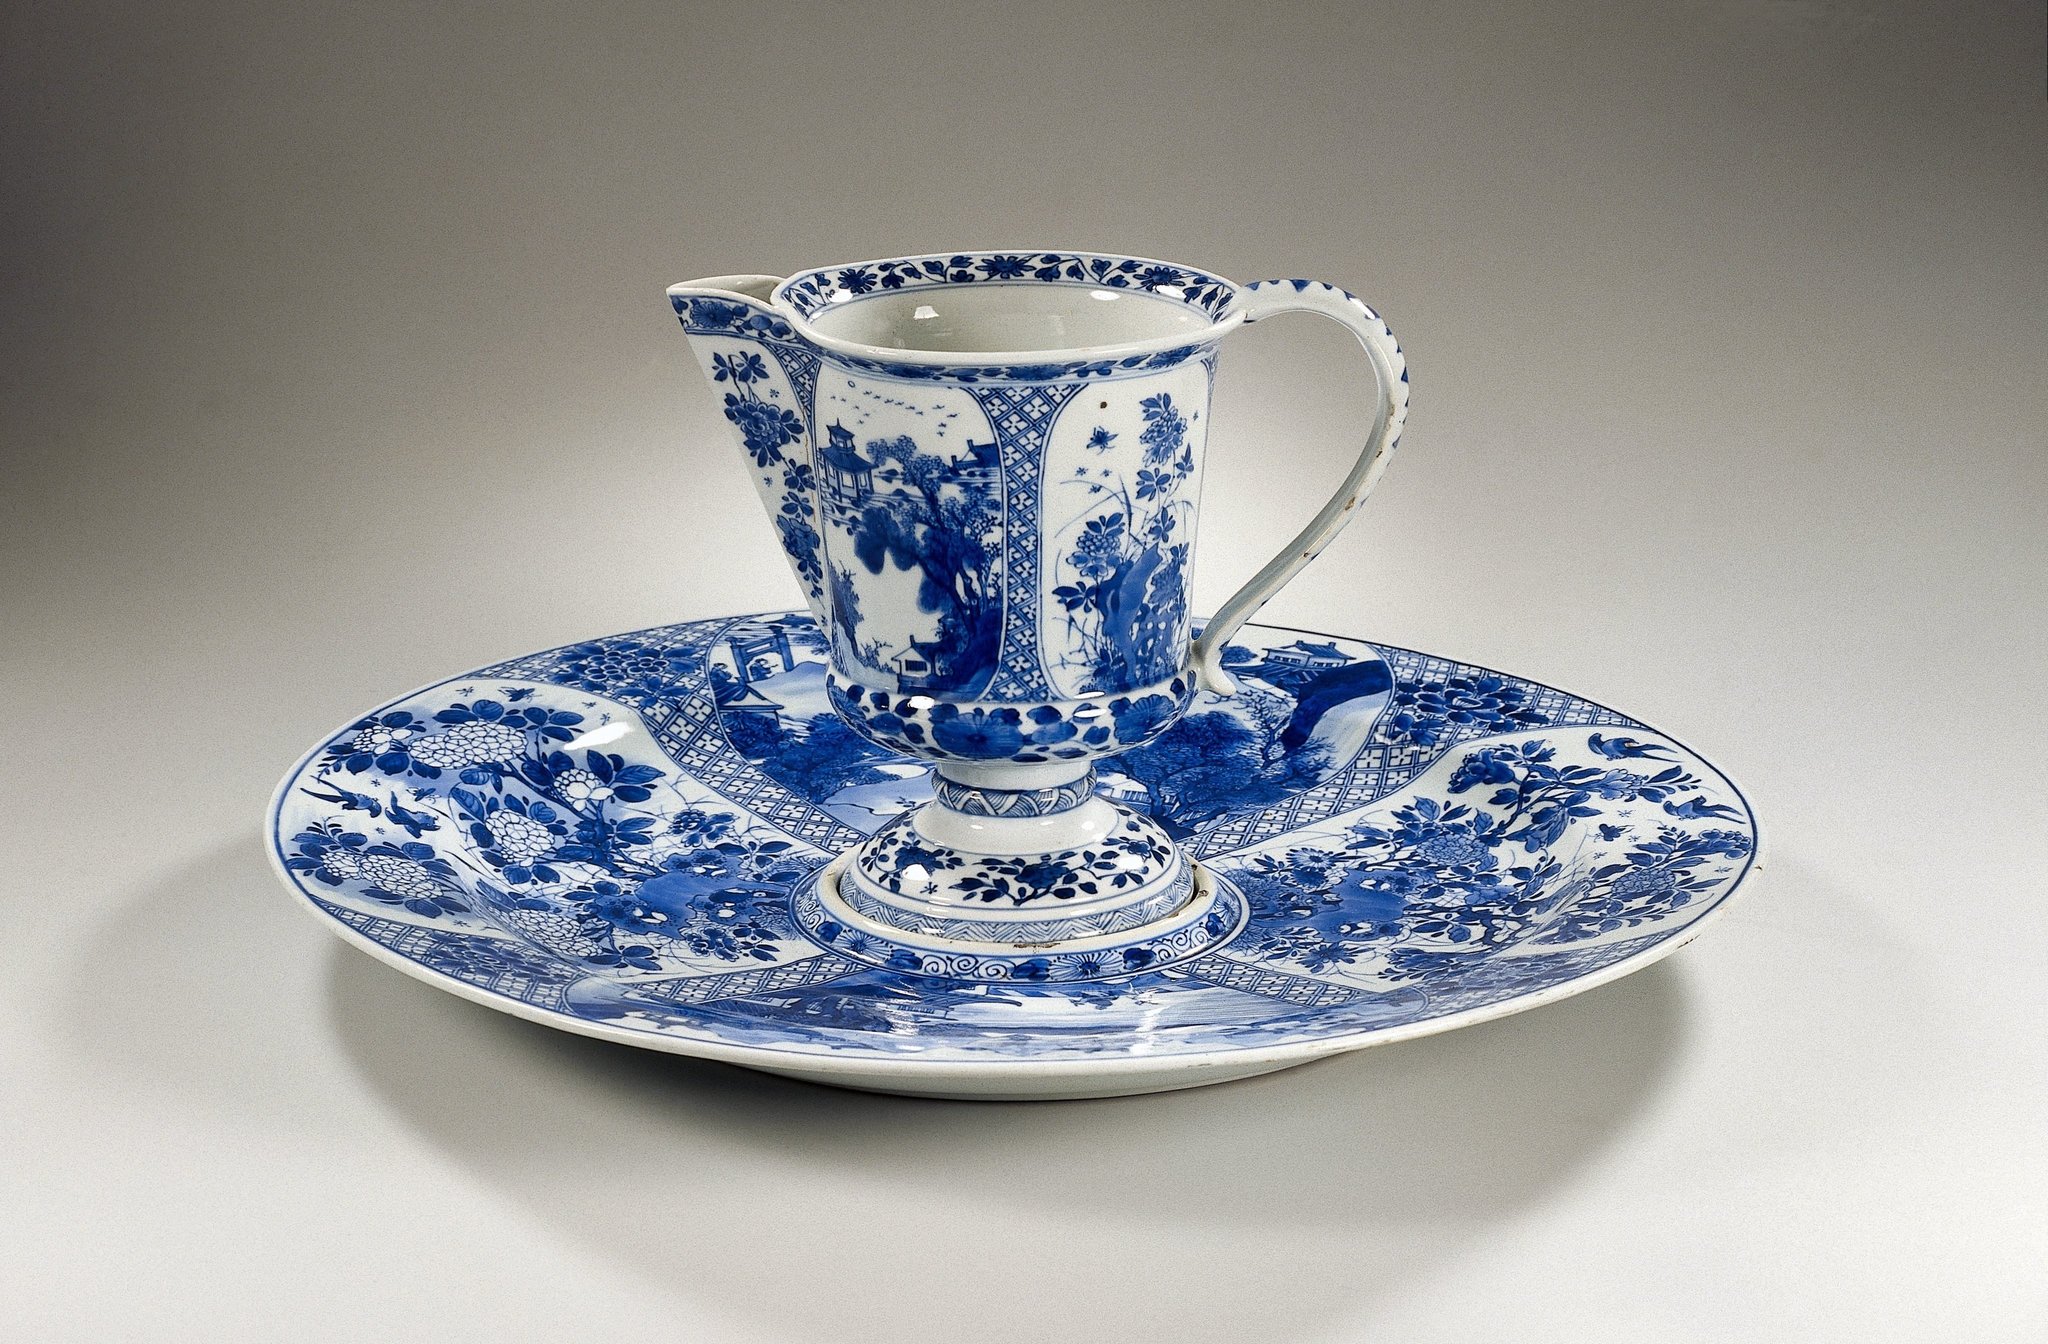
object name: platter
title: Basin with landscapes and flowering plants in panels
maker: Anonymous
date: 1700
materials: cobalt, glaze, paint, porcelain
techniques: firing, forming, turning, vitrification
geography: china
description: Lampetschotel, gedecoreerd in onderglazuur blauw met vier grote velden gevuld met bloemtakken en waterlandschapjes. De bijbehorende kan is NM-6940.